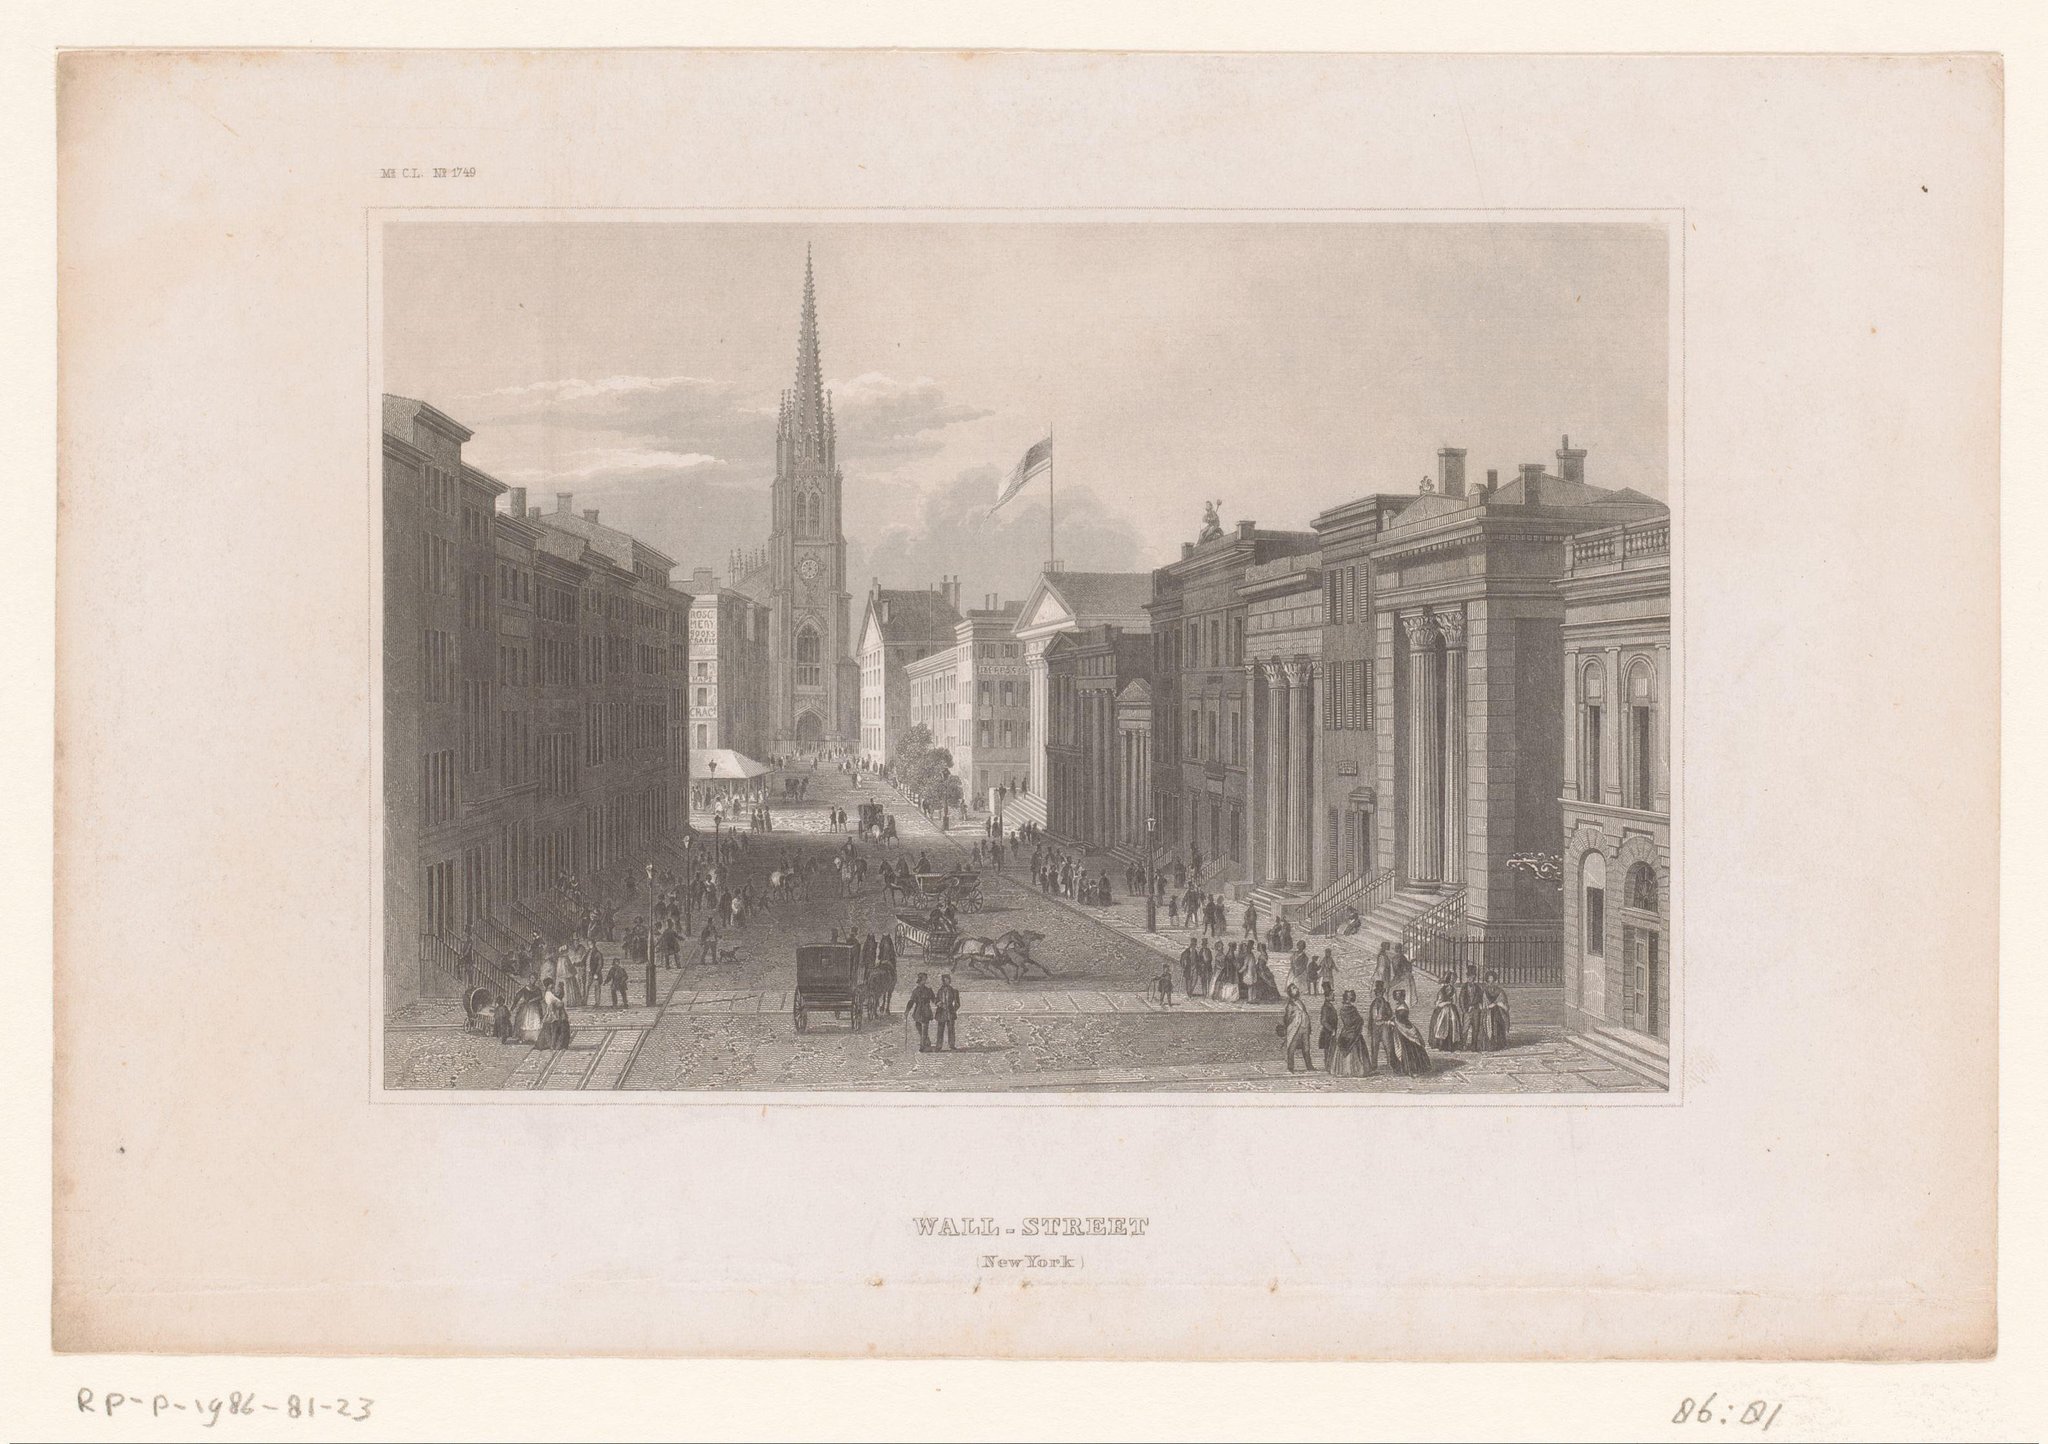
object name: print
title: Wall-Street, New York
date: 1852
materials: paper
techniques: engraving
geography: new york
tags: street, new york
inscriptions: collector's mark: Lugt 2760, collector's mark: Lugt 2228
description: Prent verschenen in: Meyer, Joseph. Meyer's Universum. New York: Hermann Julius Meyer, 1852.